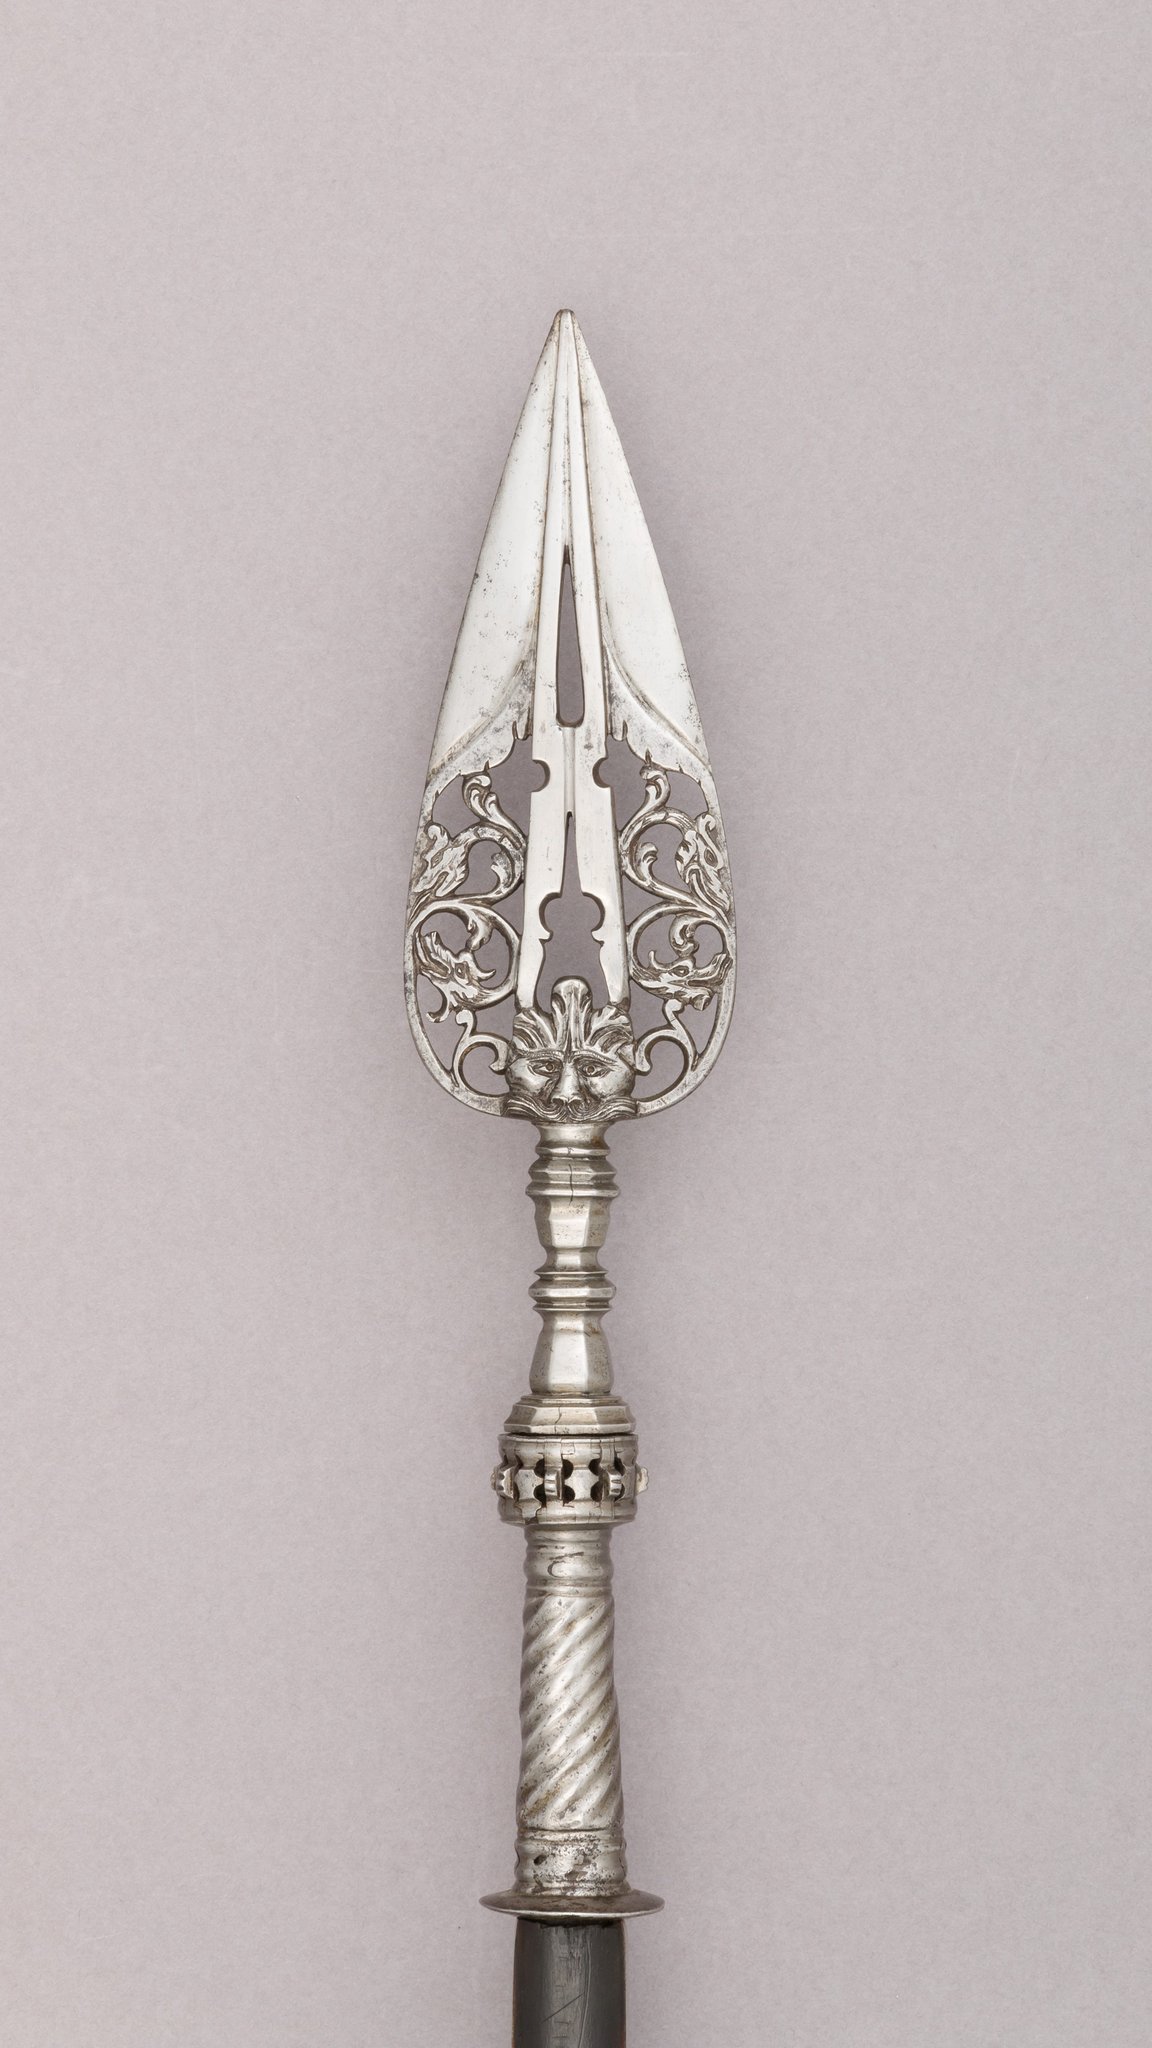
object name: spontoon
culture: french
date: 1701-1800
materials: steel, wood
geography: france